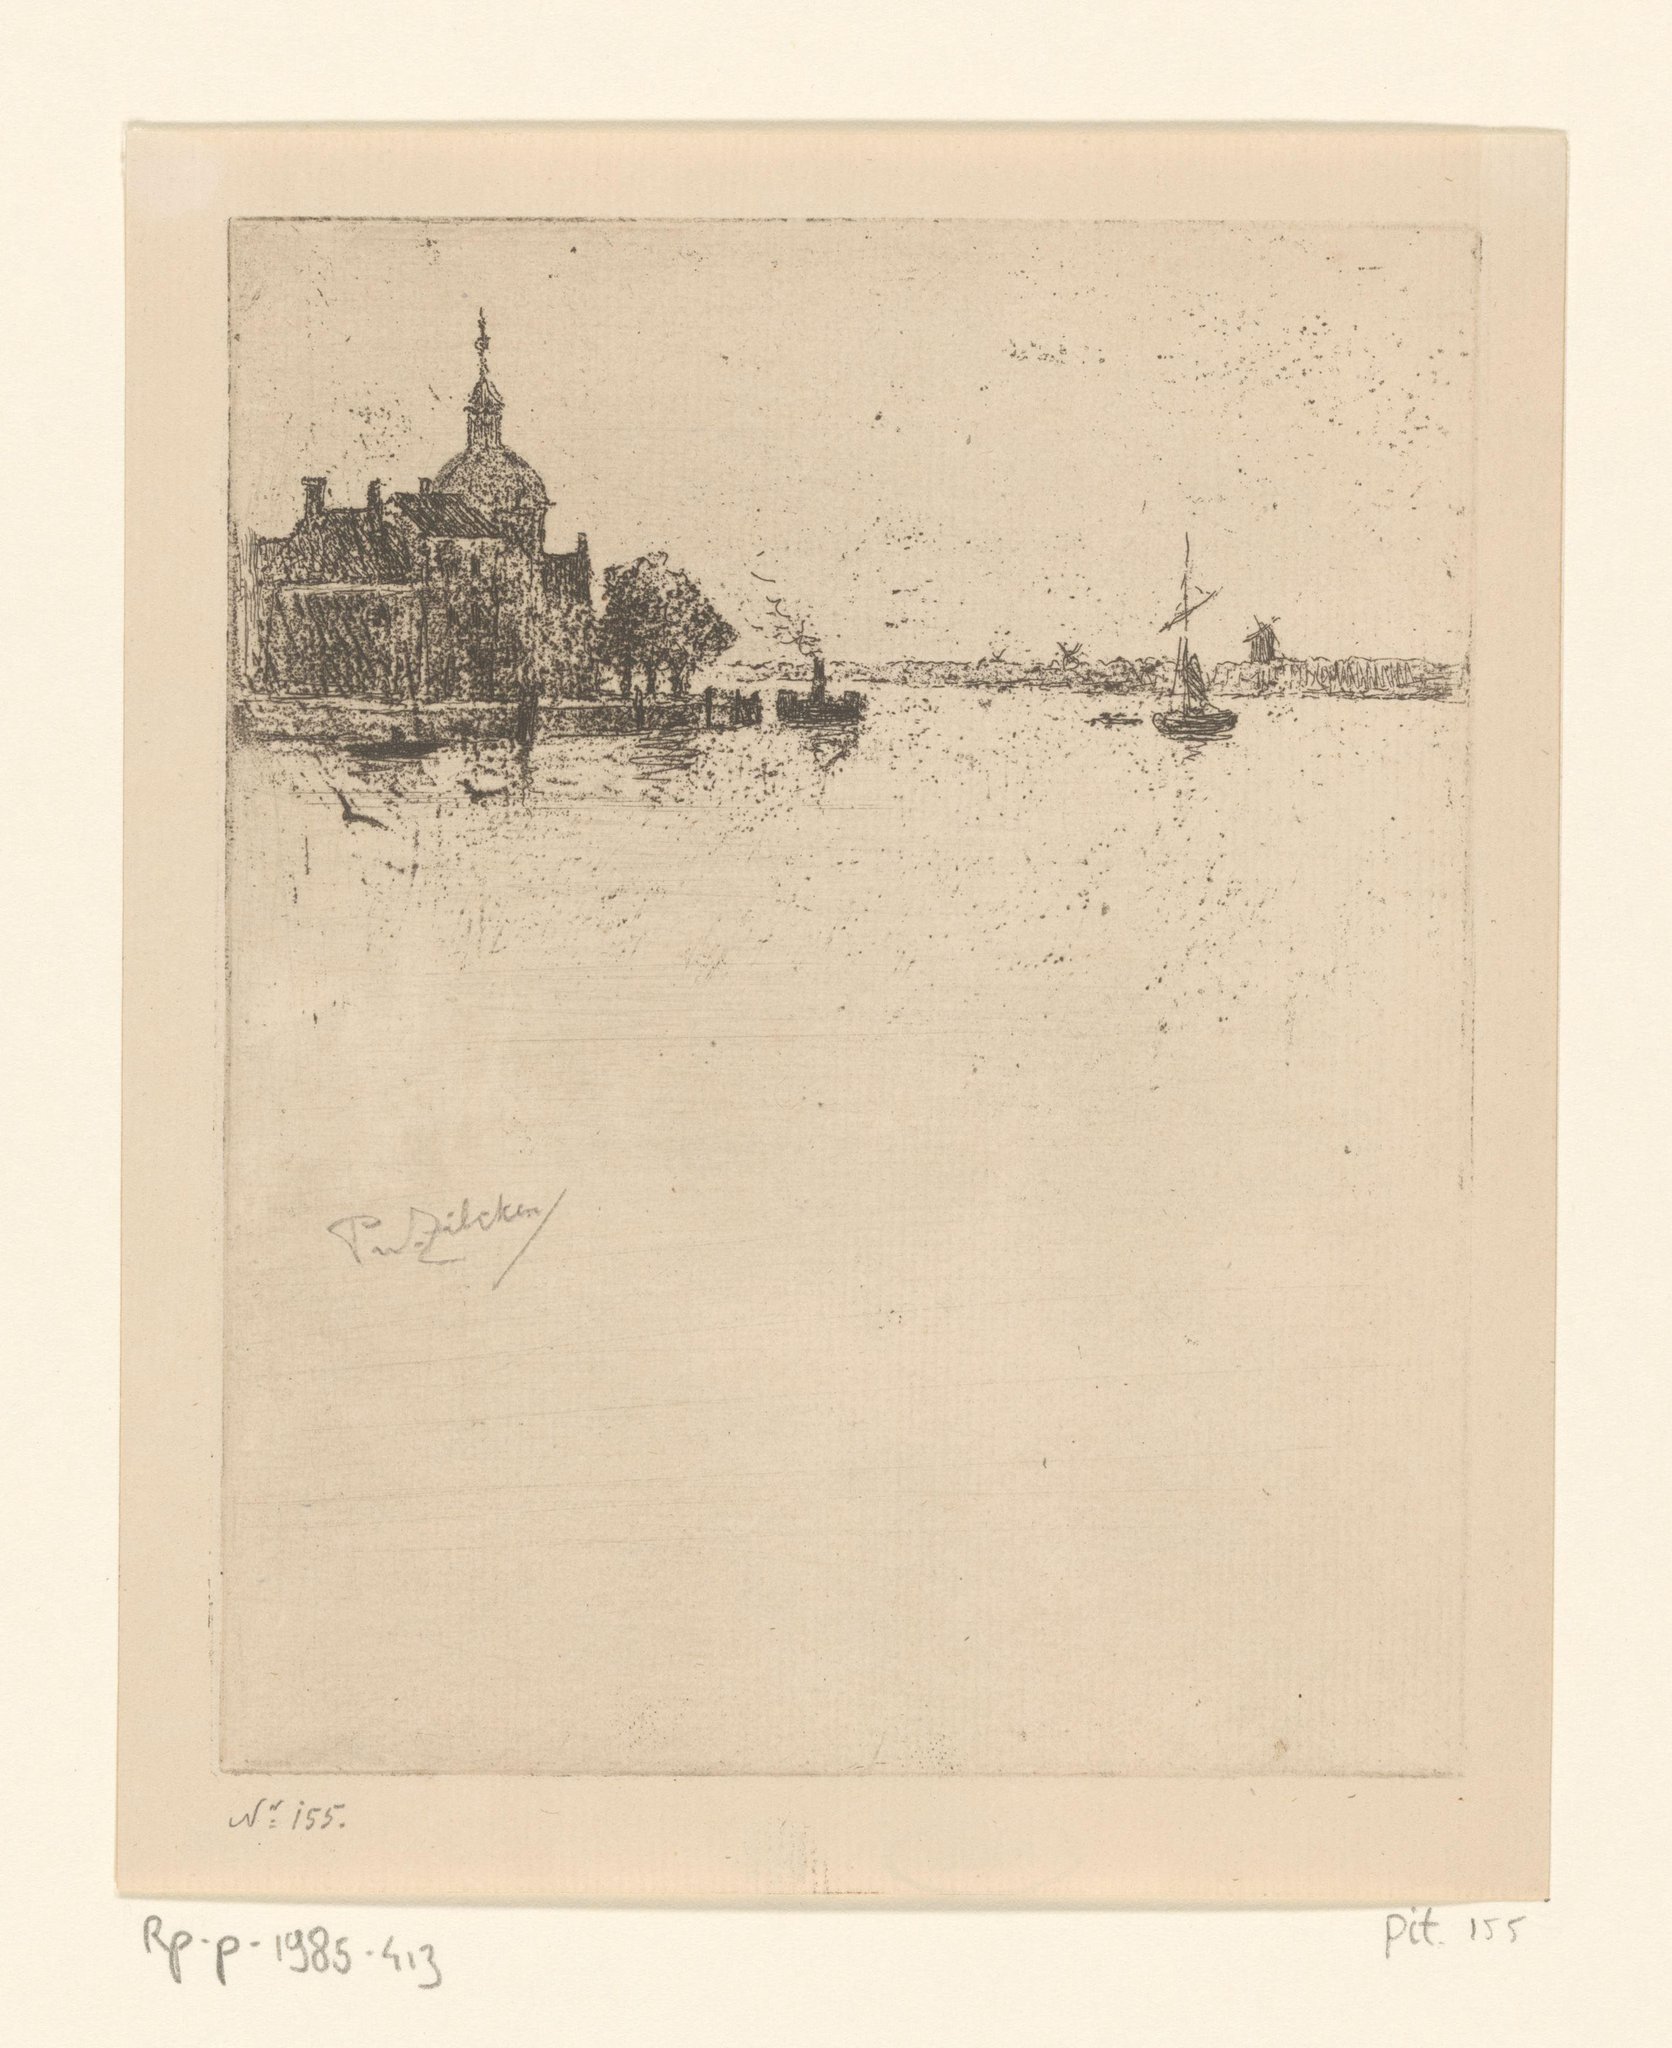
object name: print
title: Dordrecht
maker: philip zilcken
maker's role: draughtsman, painter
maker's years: 1857-1930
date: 1888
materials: paper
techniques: aquatint, drypoint, etching, intaglio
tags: city-view in general; 'veduta', river, dordrecht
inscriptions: collector's mark: Lugt 2228, collector's mark: Lugt 2760